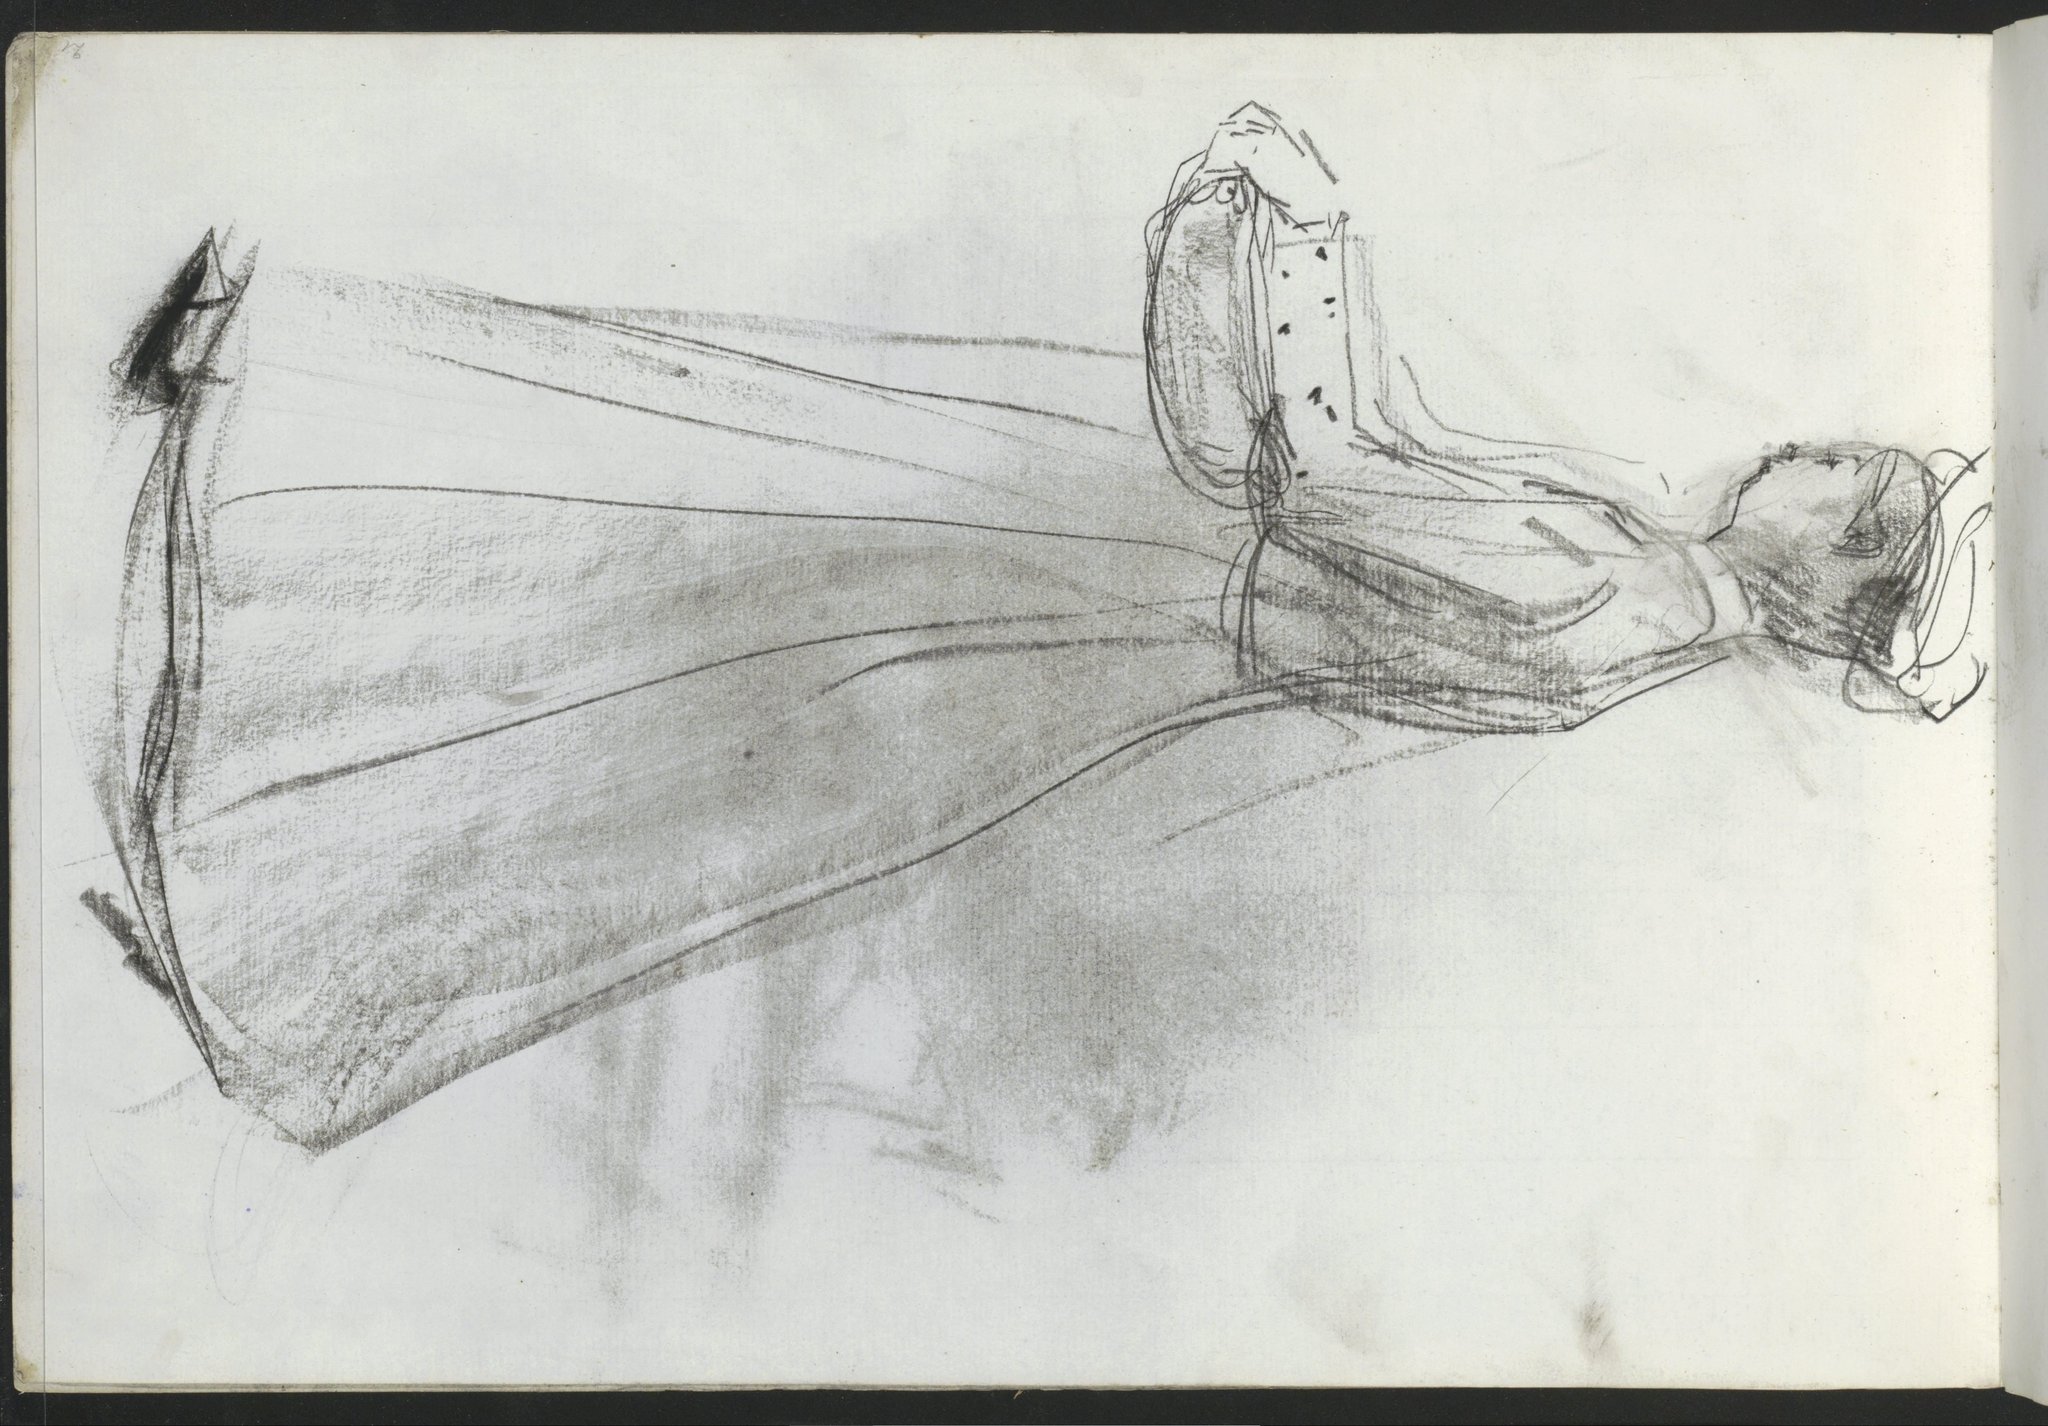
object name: sketchbook leaf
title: Dienstmeid, lopend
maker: isaac israels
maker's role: draughtsman, painter, print maker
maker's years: 1865-1934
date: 1886-1934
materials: chalk, paper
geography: amsterdam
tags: bowl, maid ~ house personnel, walking - aa - female human figure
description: In haar handen mogelijk een kom. Blad 14 verso uit schetsboek LXX met 17 bladen.